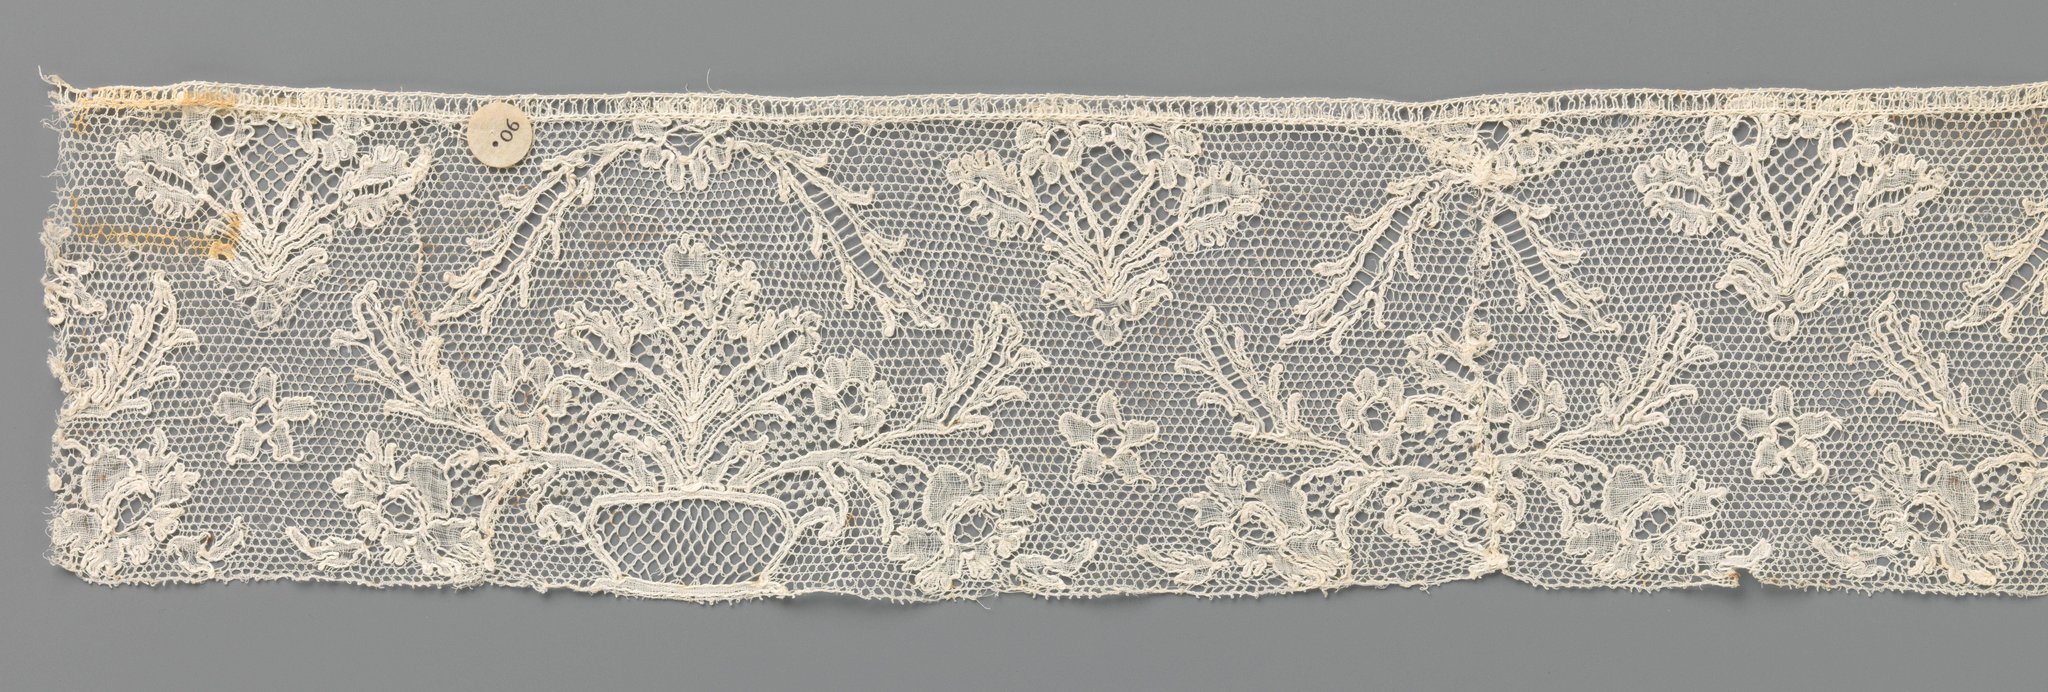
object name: strip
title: Strook kloskant met anjers in bloempot en v-vormig boeketje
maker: Anonymous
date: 1750-1799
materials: linen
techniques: lace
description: Strook naturelkleurige kloskant, Parijse pottekant. Het zich herhalende patroon bestaat uit een eenvoudig vormgegeven bloempot met kleine oren, waarin een symmetrische boeket staat. De bloemen in het boeket nemen vanuit de top in grootte toe, aan weerszijden van de pot eindigend met een grote overhangende anjer. Tussen de opeenvolgende bloempotten in staat langs de bovenzijde een v-vormig boeketje, met recht daaronder een losse rozetbloem. De motieven zijn met elkaar verbonden door een maasgrond, de Parijse grond. De motieven zijn gemaakt in linnenslag met dikkere en glimmende contourdraden. Verschillende siergronden zijn toegepast, onder andere in de bloempot, de bloemharten en tussen de bloemen in. De bovenzijde is afgewerkt met een apart geklost bandje, het patroon loopt er deels in door, waarschijnlijk is de bovenrand ooit beschadigd geweest en is er toen een nieuw bandje aangezet. De onderzijde is recht afgewerkt en voorzien van picots.